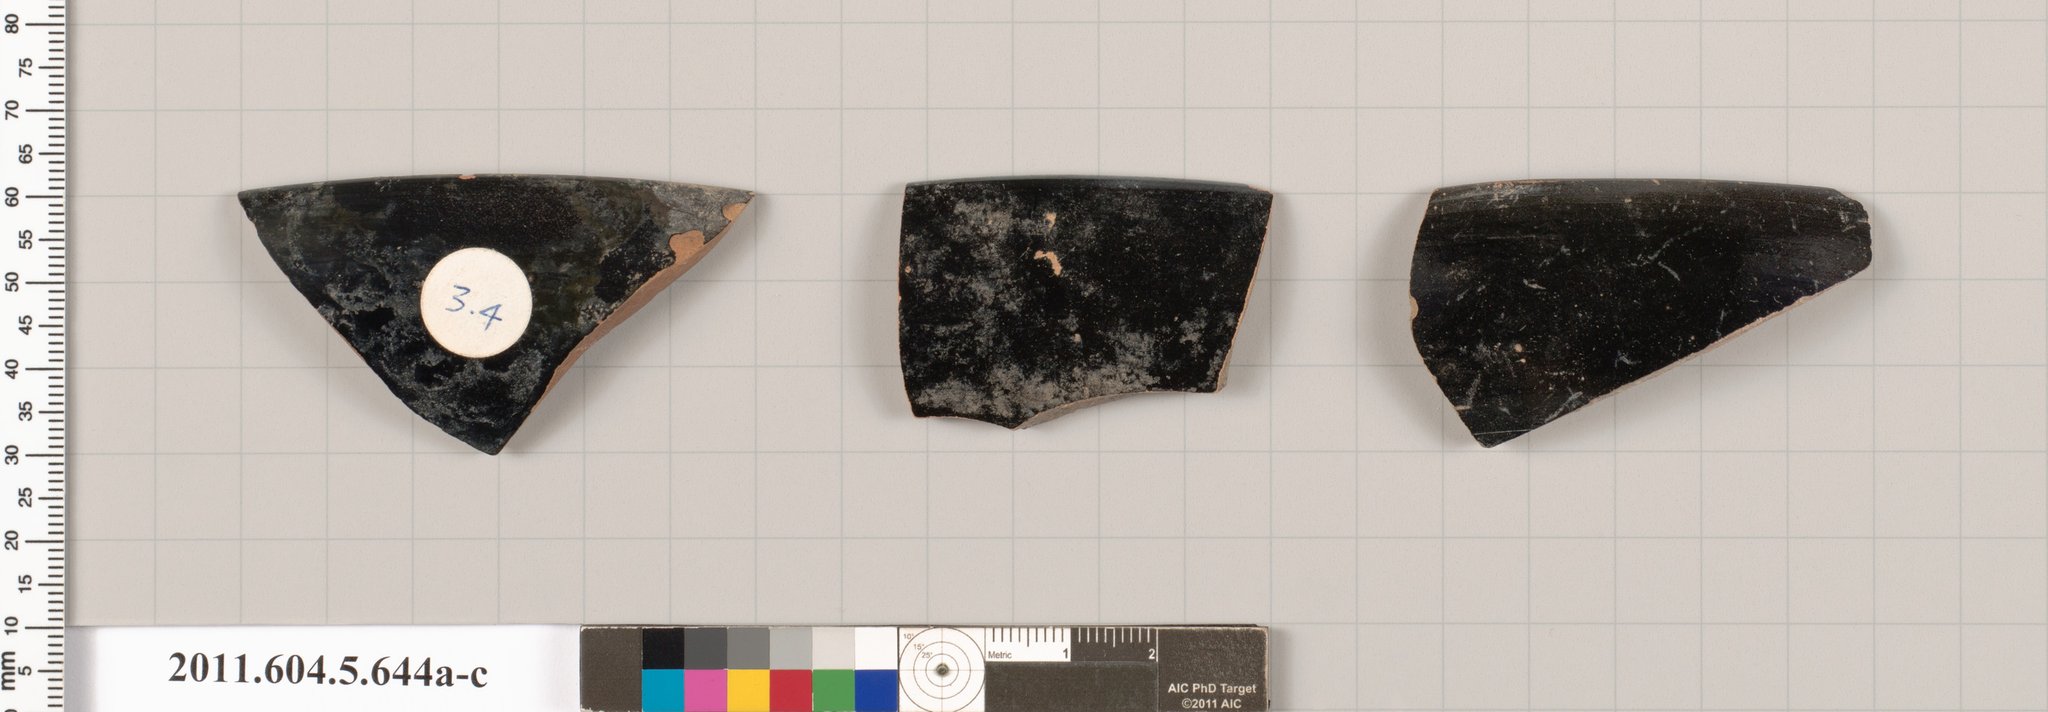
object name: kylix fragment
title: Terracotta rim fragments of kylikes (drinking cups)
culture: greek, attic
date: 600-401 BCE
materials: terracotta